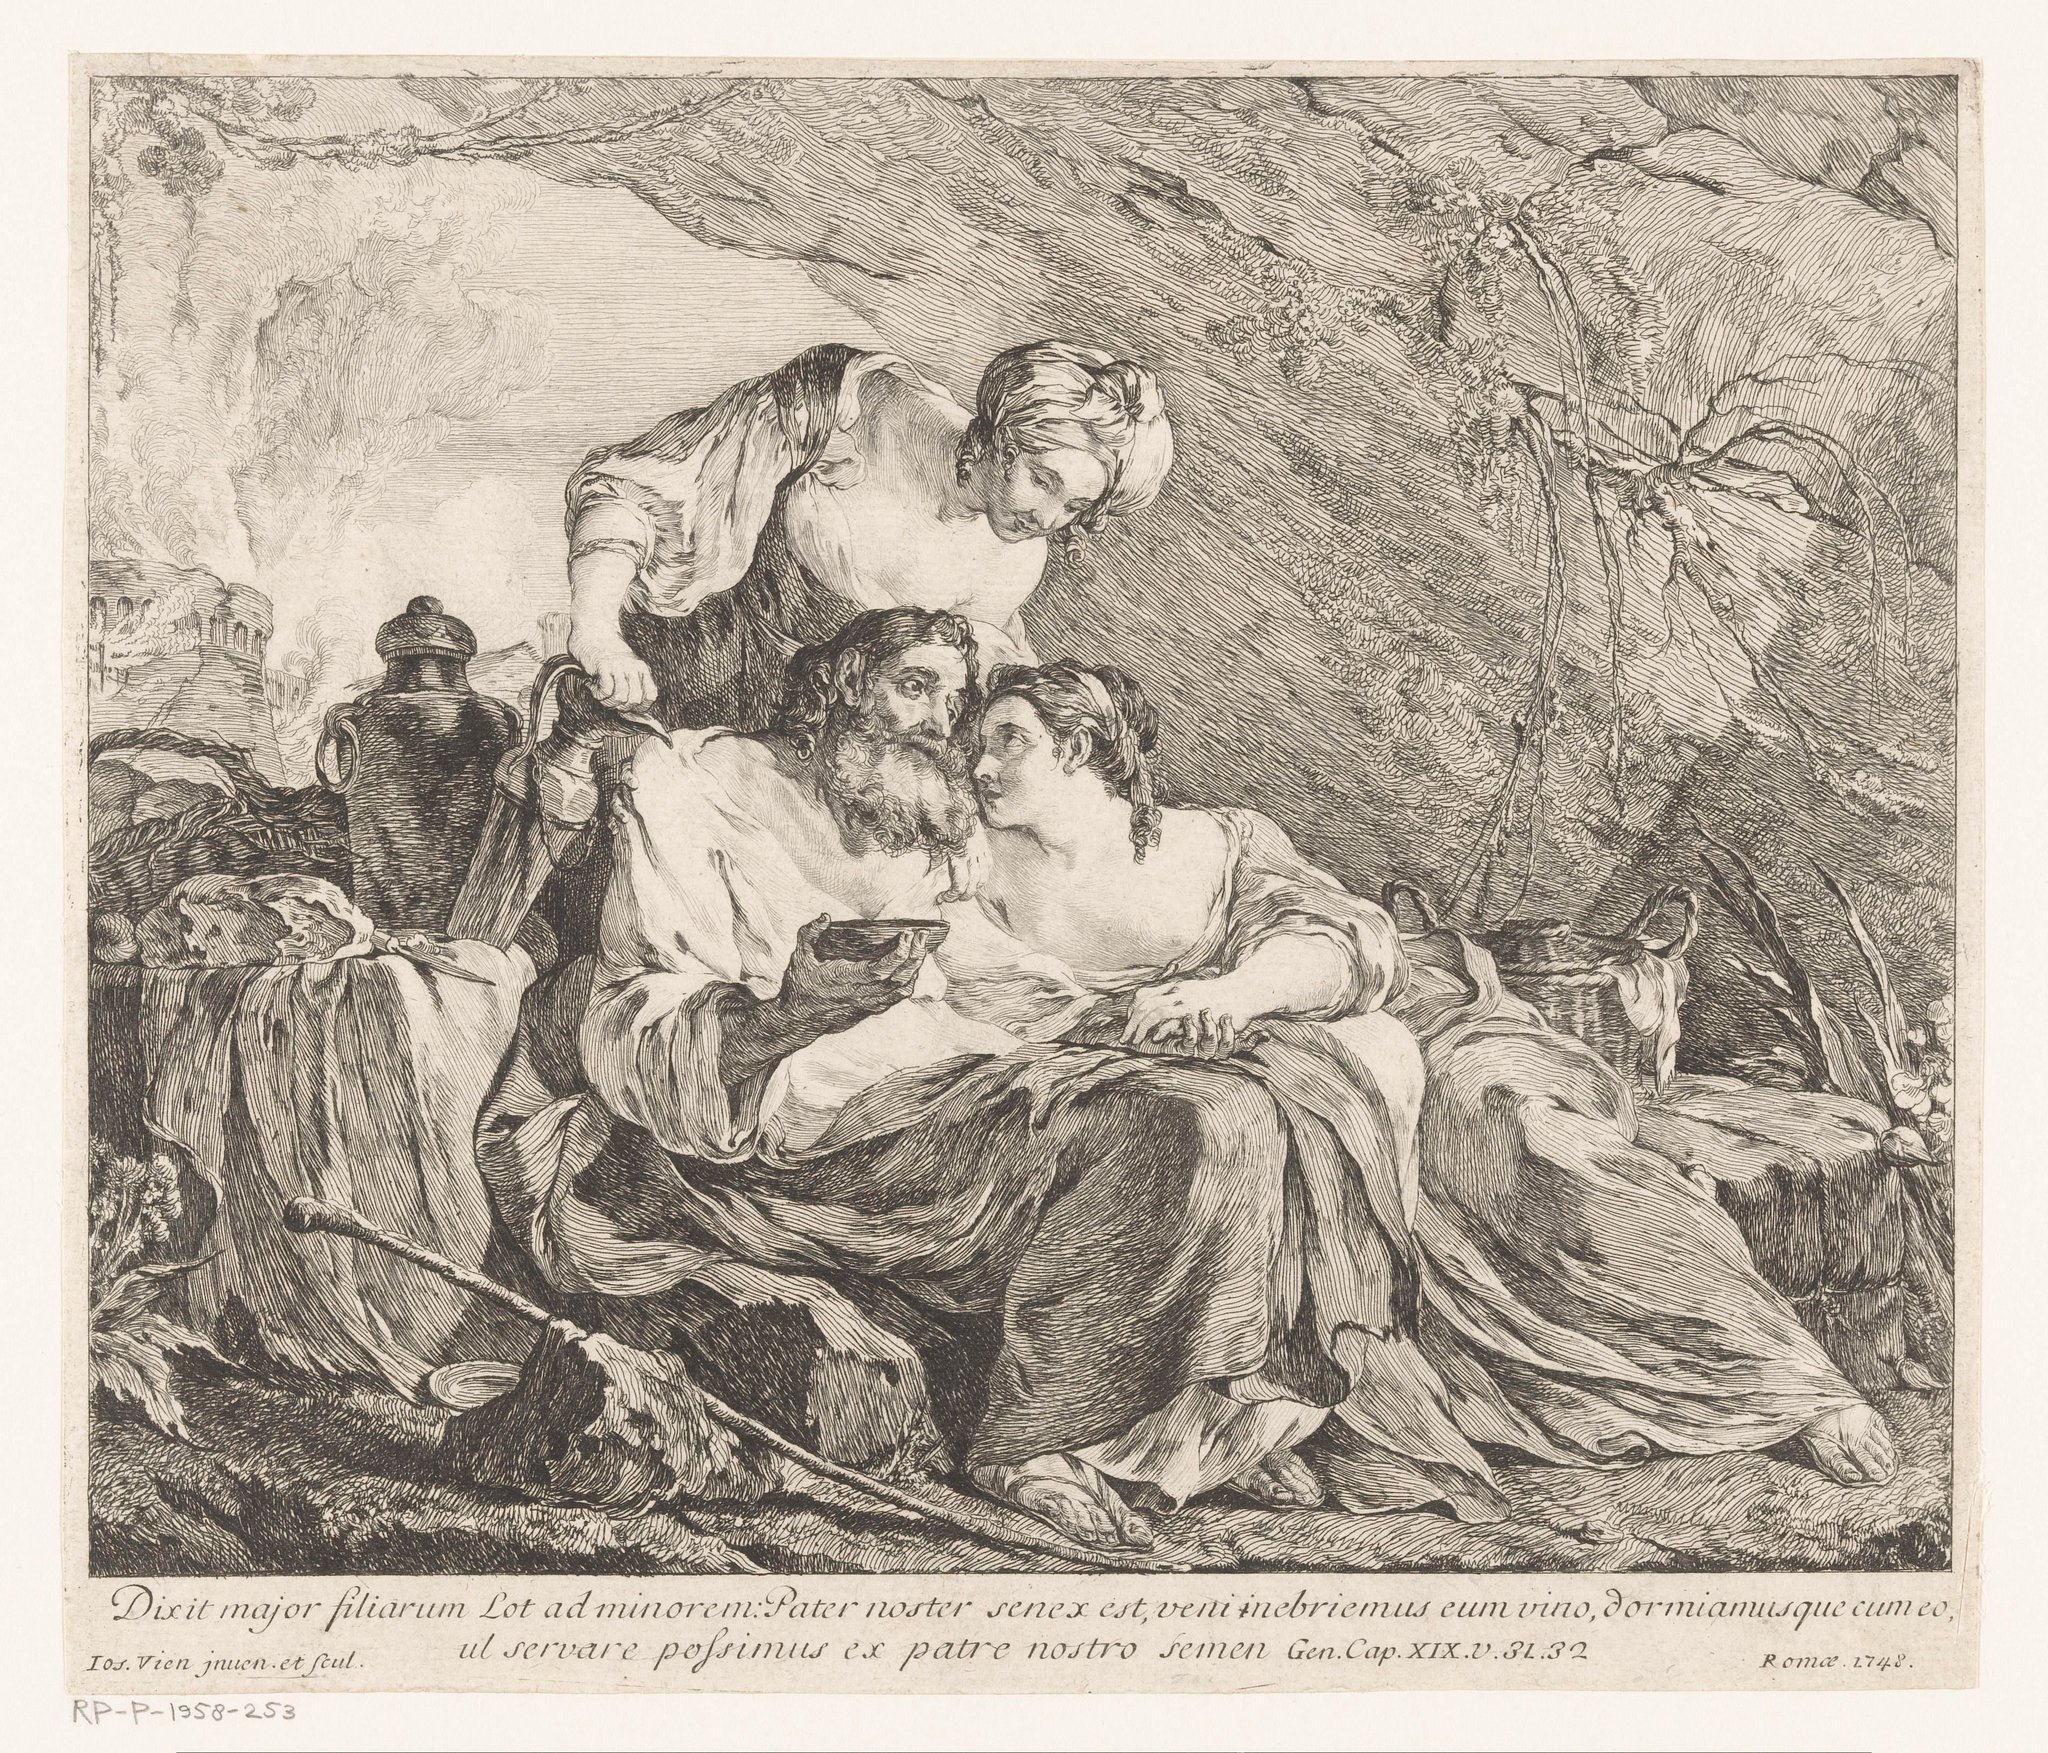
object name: print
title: Lot en zijn dochters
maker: joseph-marie vien (i)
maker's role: painter, print maker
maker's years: 1716-1809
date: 1748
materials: paper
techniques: etching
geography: rome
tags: lot's daughters make their father drunk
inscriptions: collector's mark: Lugt 2228, collector's mark: Lugt 2760, collector's mark: Lugt 739, collector's mark